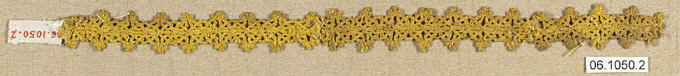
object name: fragment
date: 1501-1600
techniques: lace